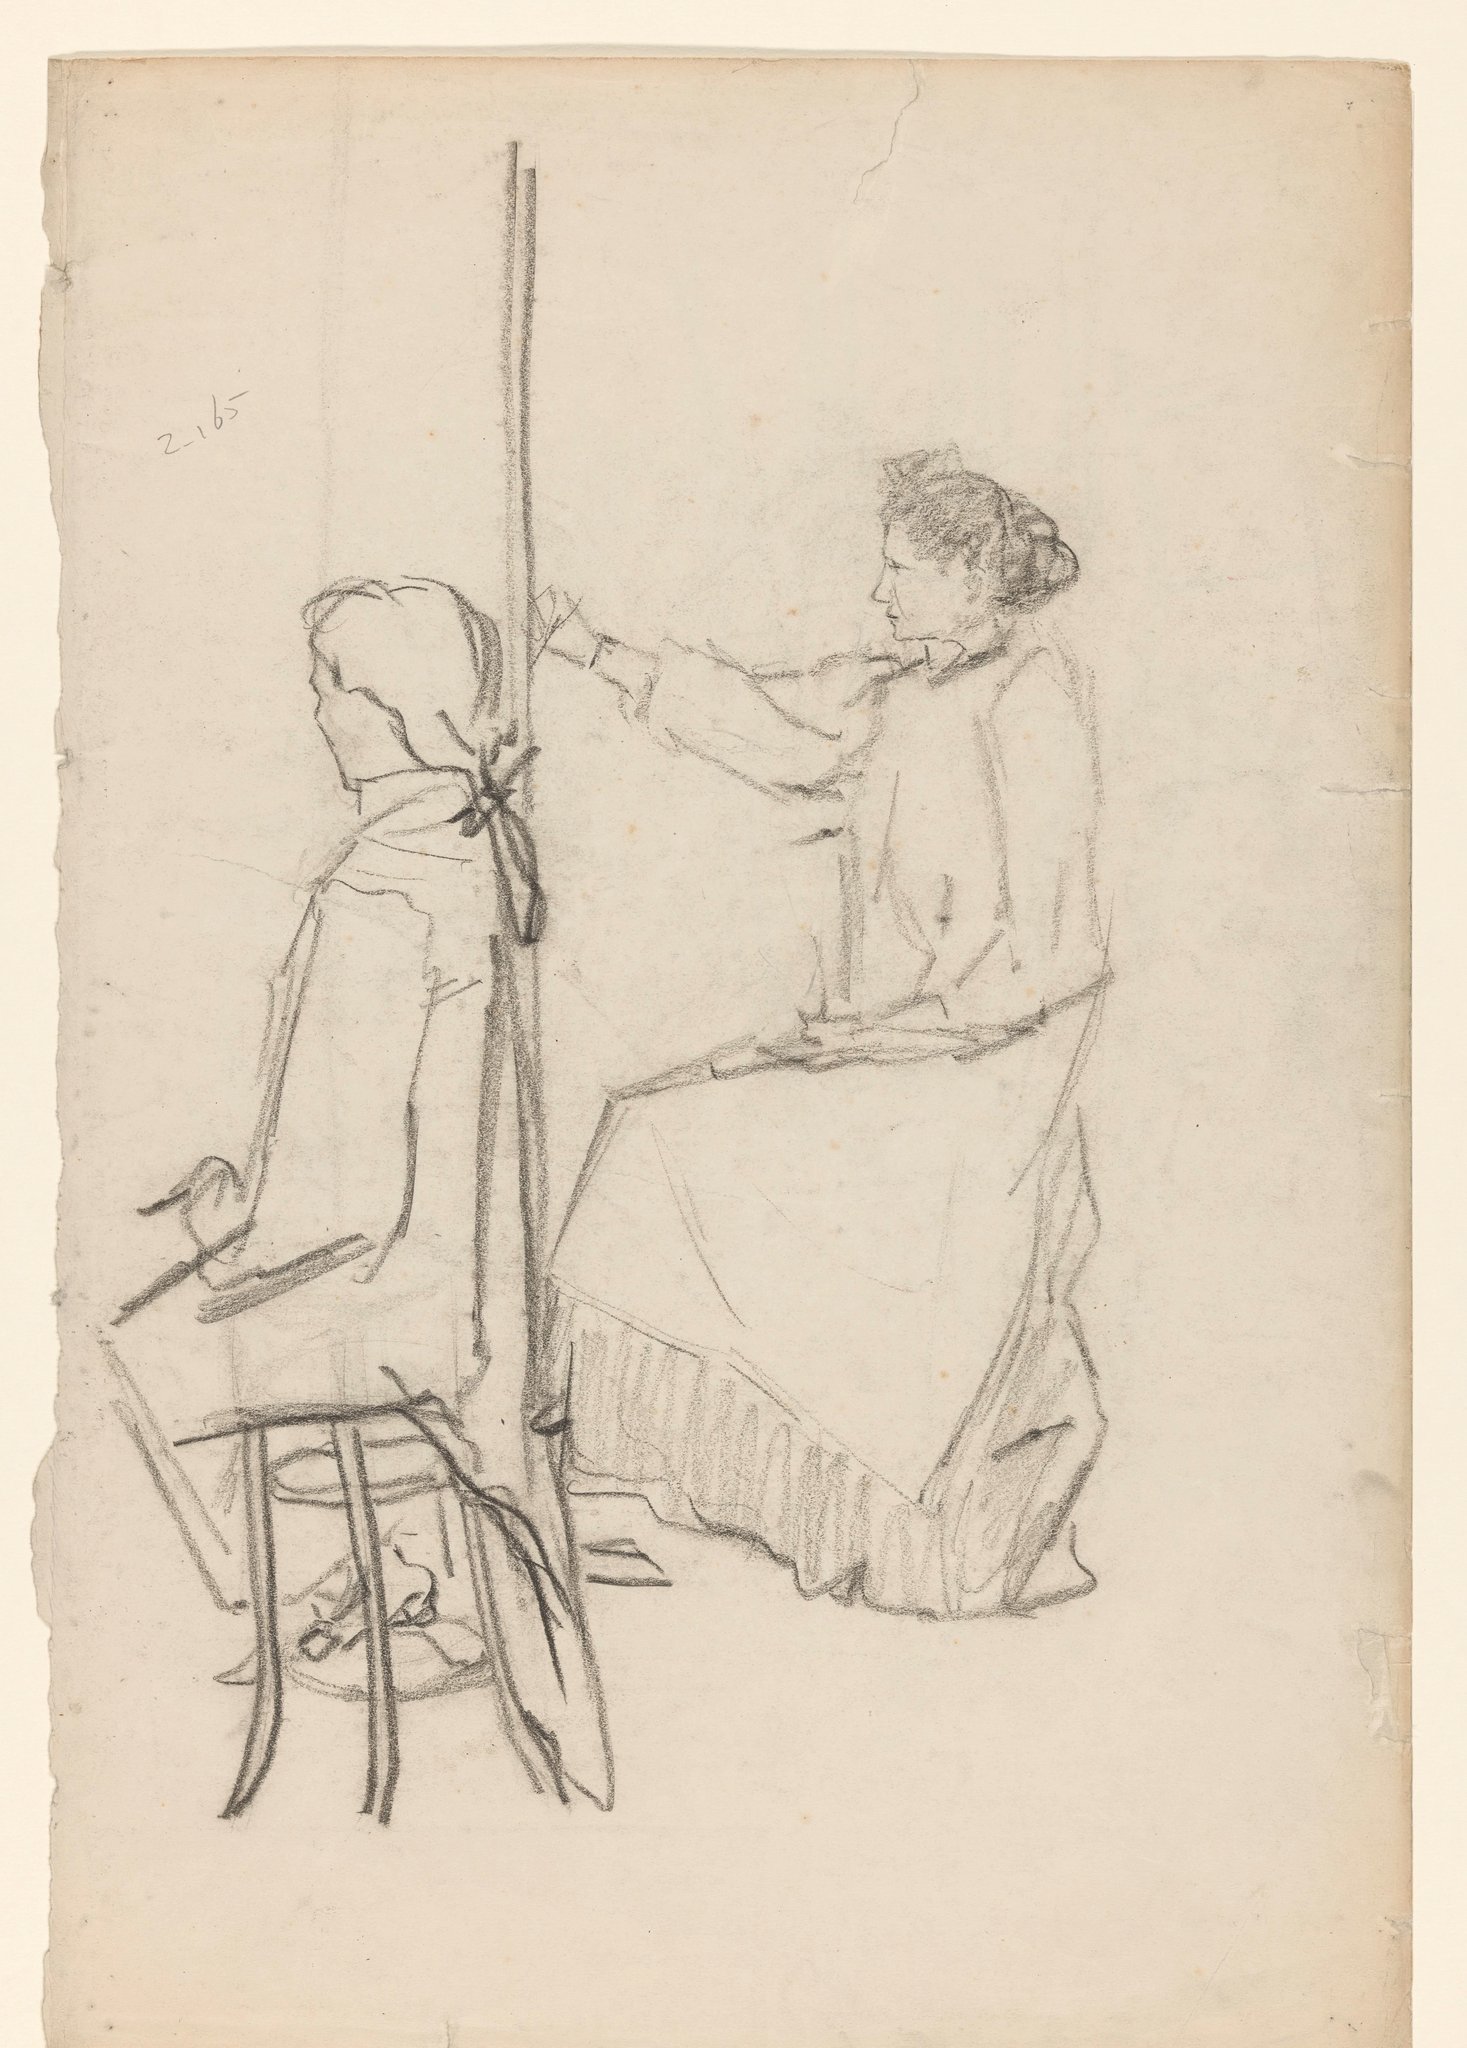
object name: drawing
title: Tekenende leerlingen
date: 1855-1930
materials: chalk, paper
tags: drawing-lesson